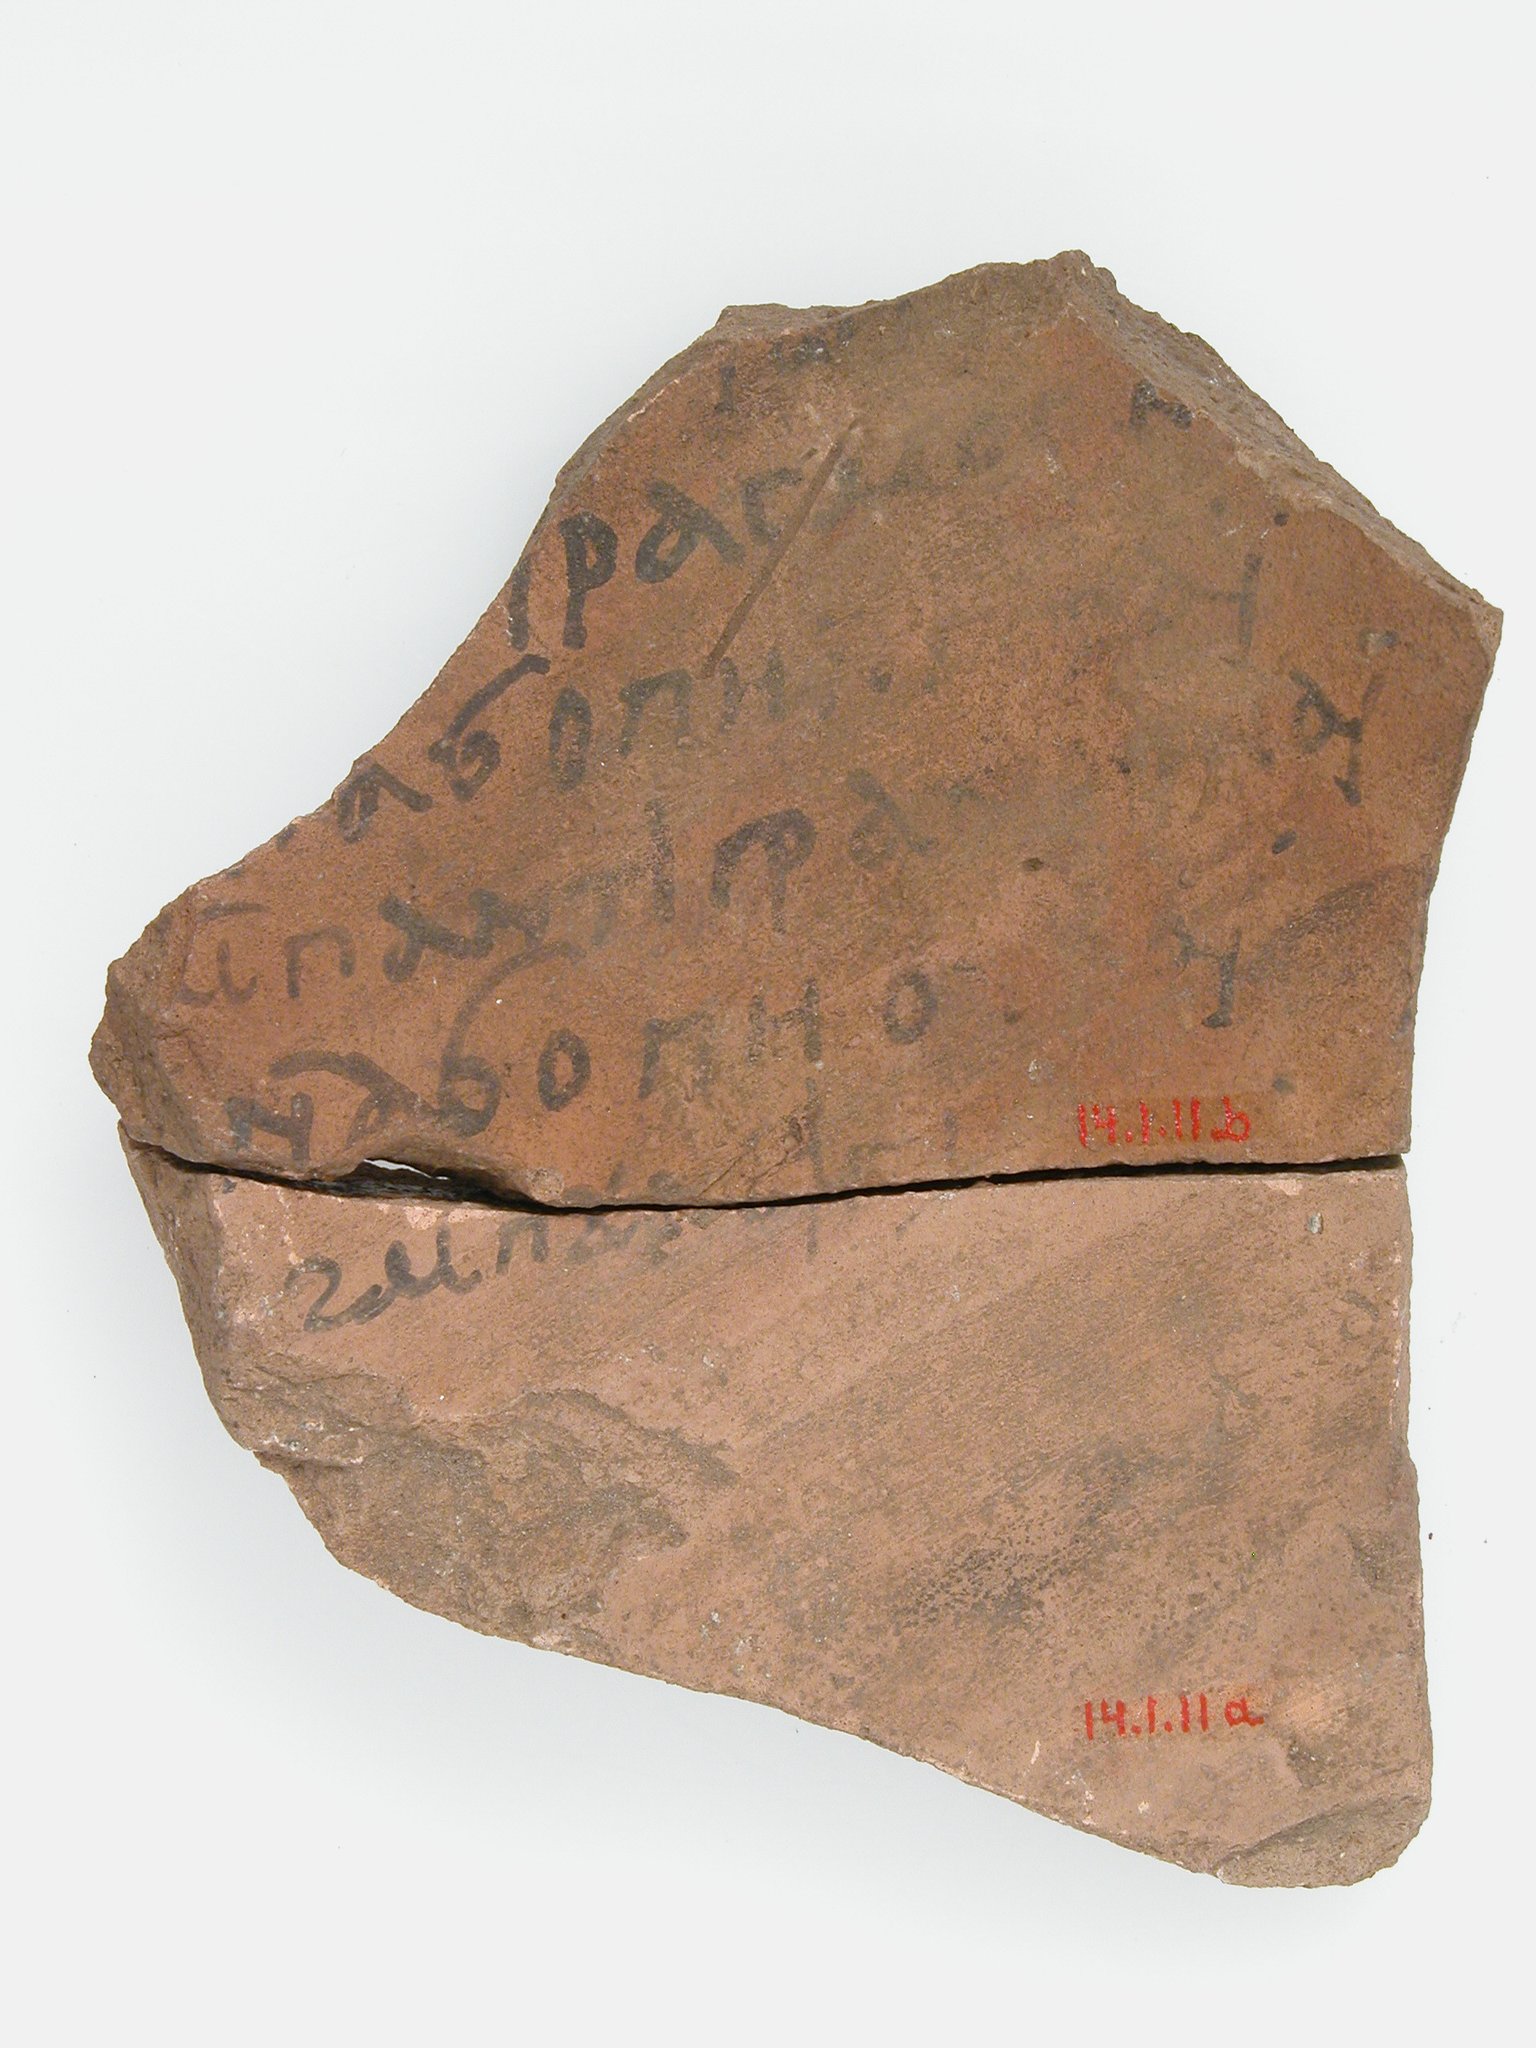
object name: ostrakon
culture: coptic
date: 600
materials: ink, pottery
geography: egypt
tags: coptic,documents